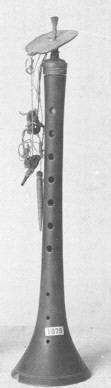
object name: zurna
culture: turkish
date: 1867-1900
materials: wood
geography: turkey